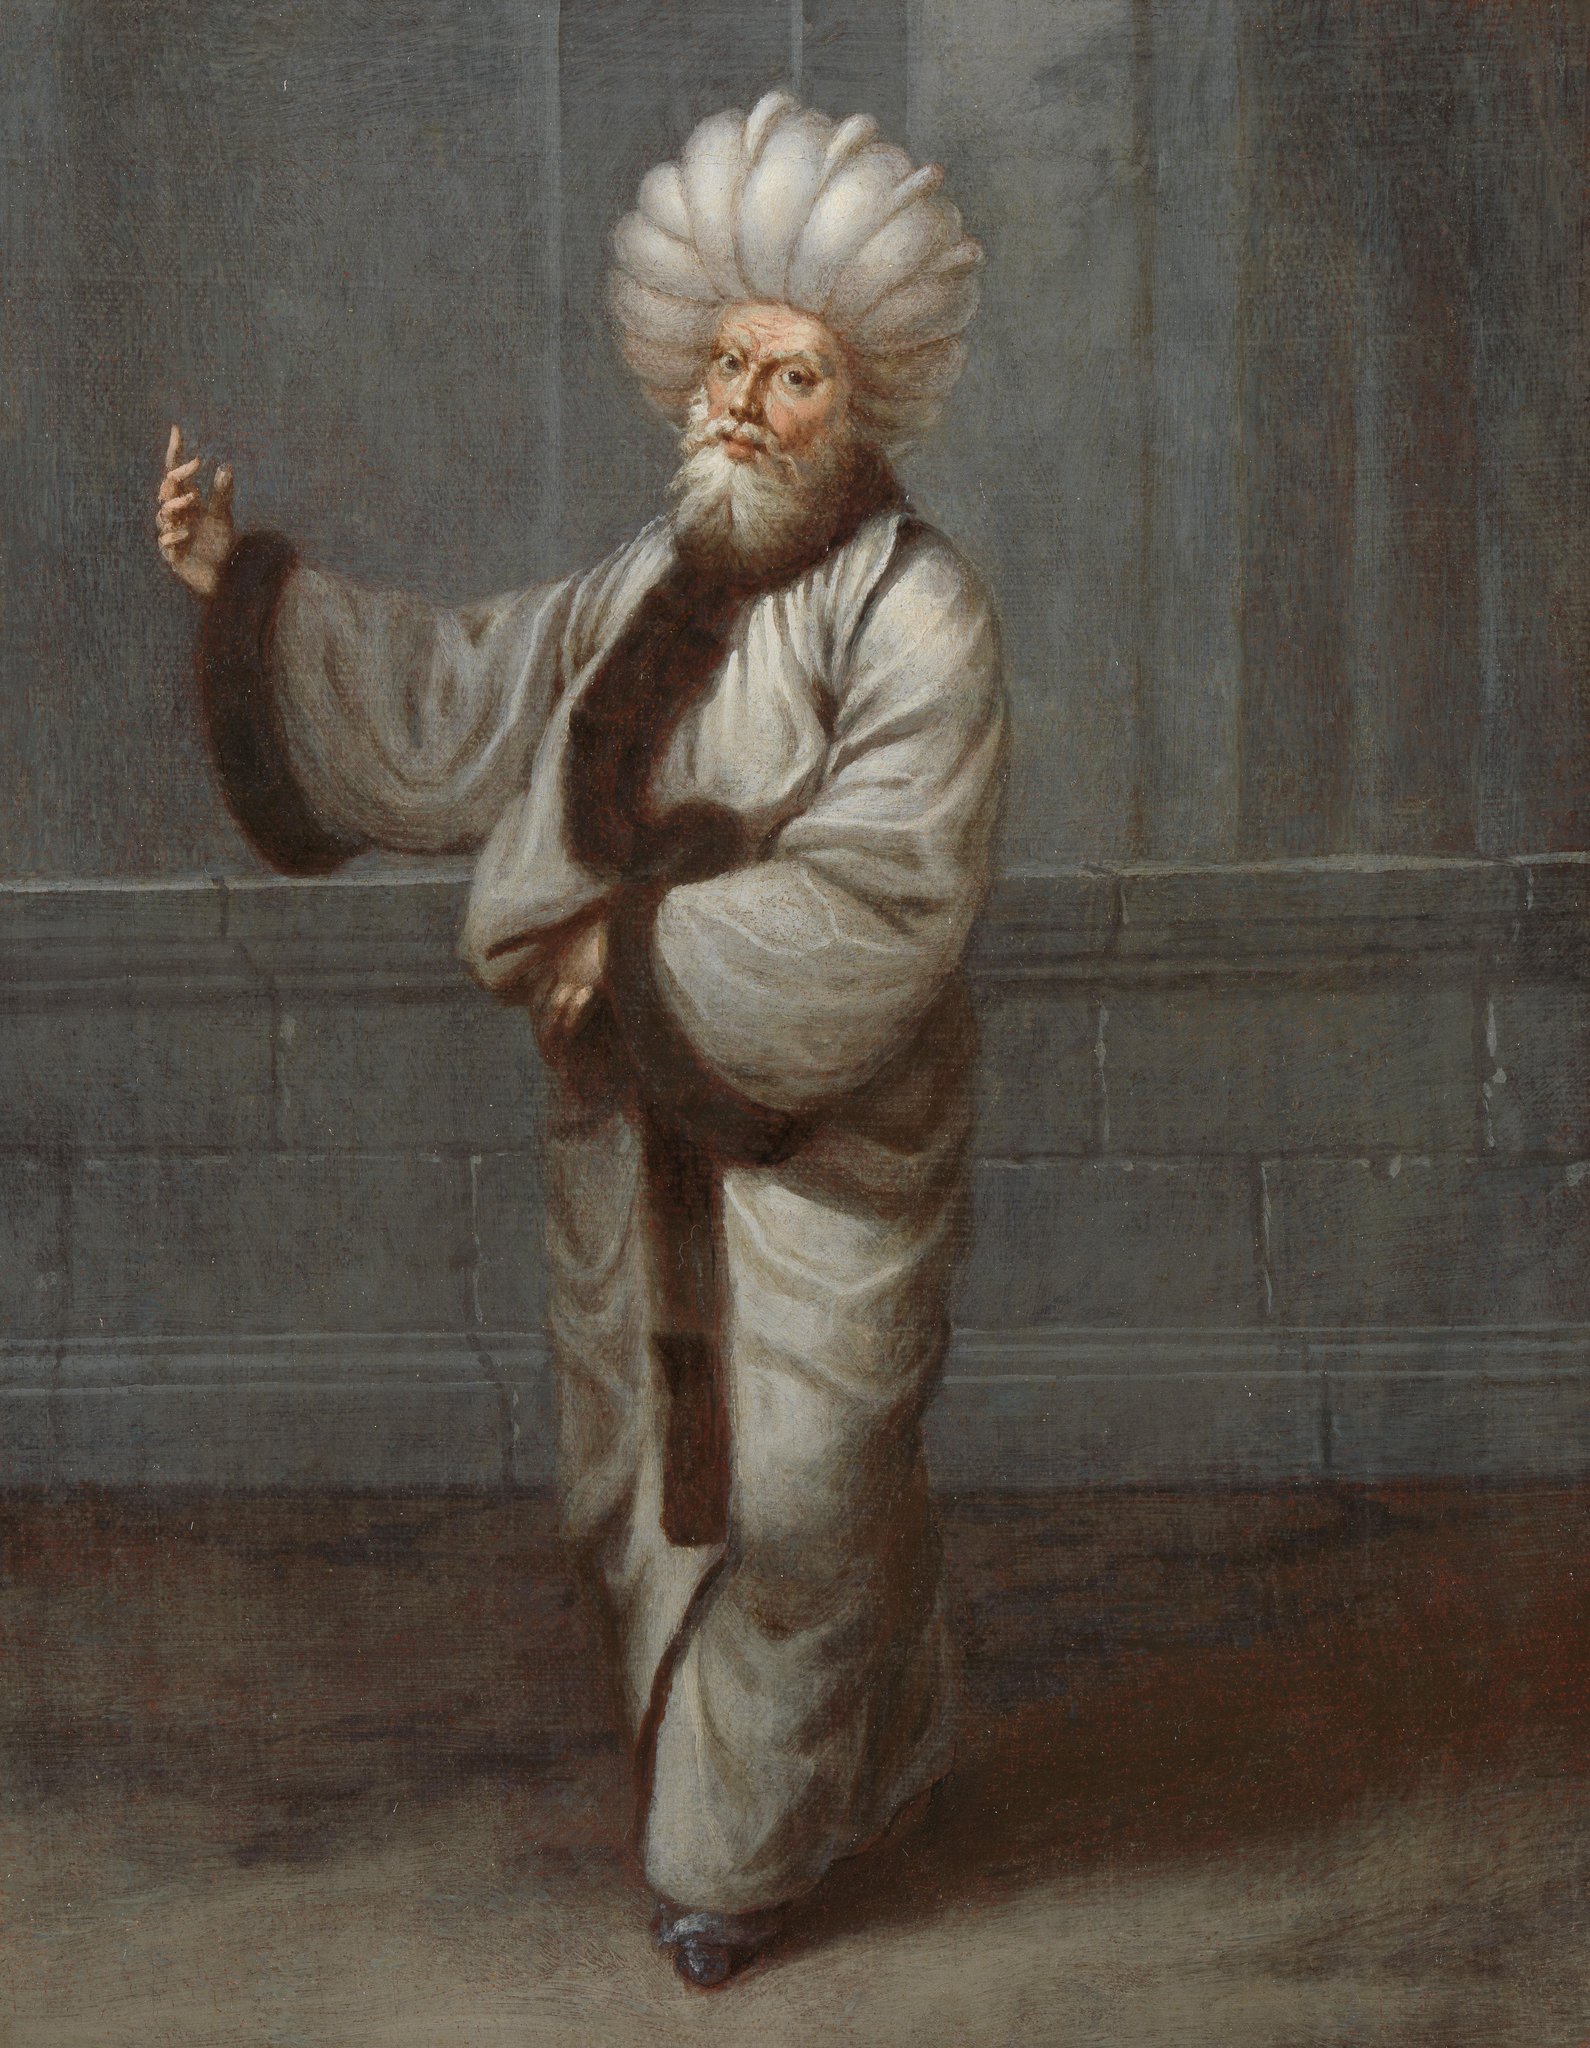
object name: painting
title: The Kazasker, Judge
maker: jean baptiste vanmour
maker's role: painter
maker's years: 1671-1737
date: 1727-1730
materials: canvas, oil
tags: standing figure, head-gear: turban, magistracy, judges, historical persons not known by name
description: This is one of the kadı ‘askerı. They were the two chief military judges in the Ottoman Empire. One judge was responsible for the region of Rumelia (the European part of the empire), the other for the region of Anatolia (the Asiatic part). They could be recognized by their large turbans and fur-trimmed cloaks.